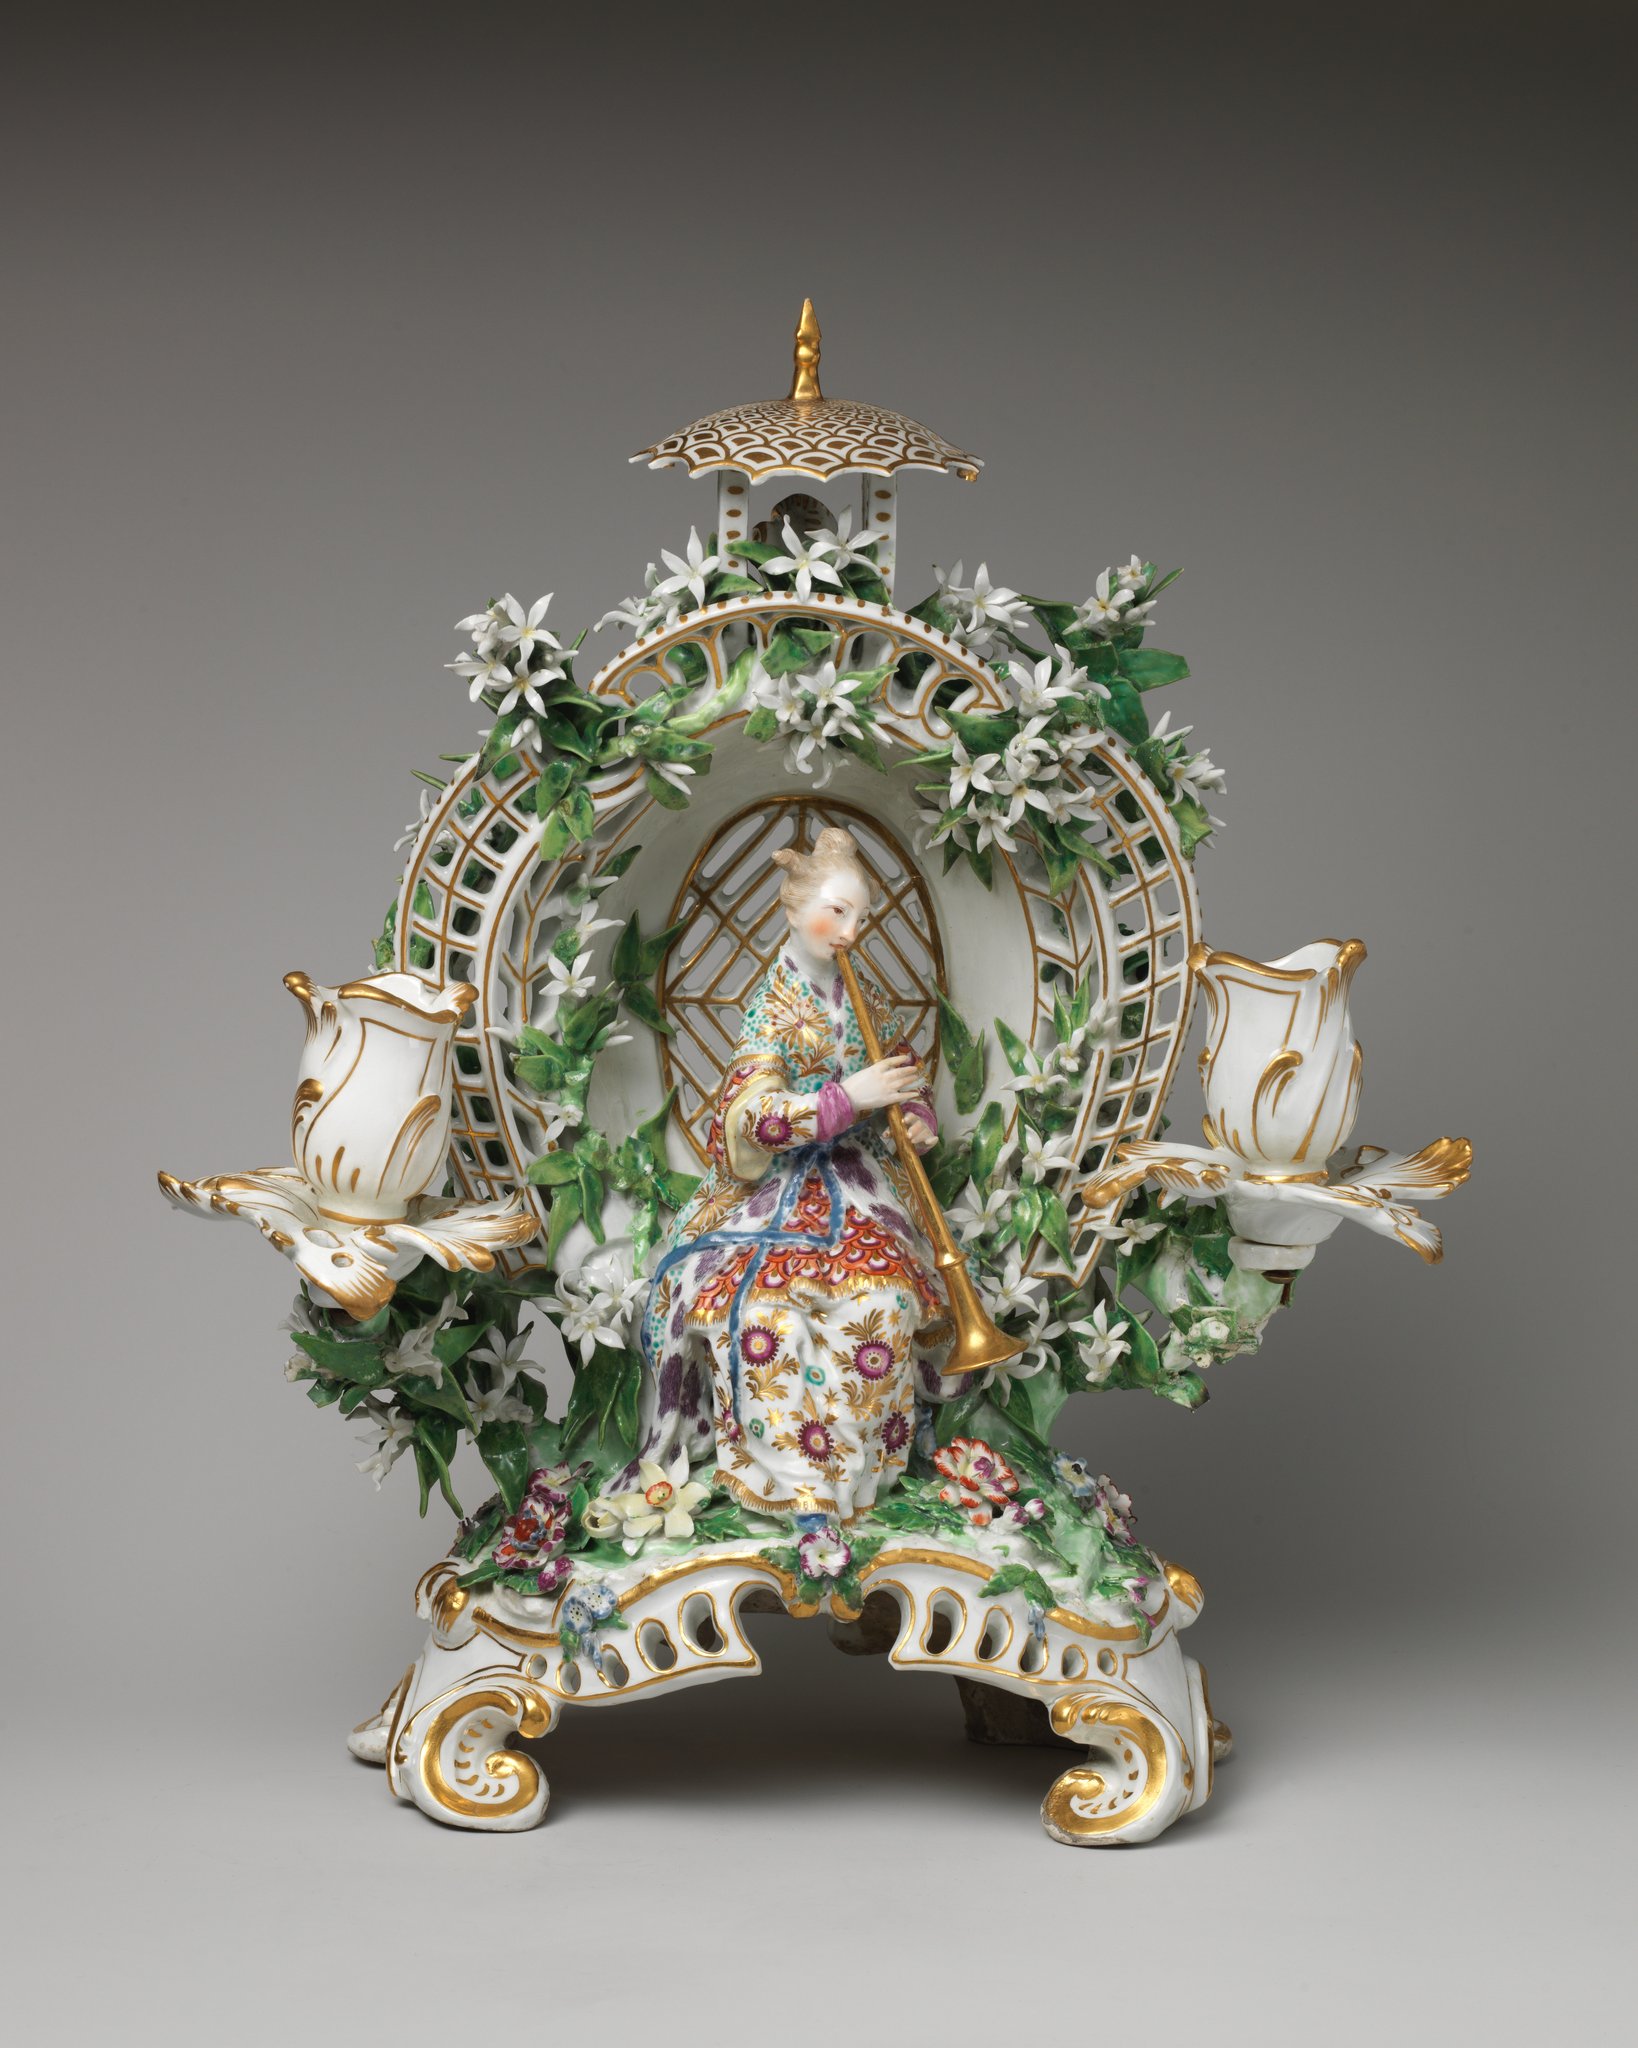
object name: candelabrum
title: Candelabrum (one of a pair)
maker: chelsea porcelain manufactory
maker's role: factory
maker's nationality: british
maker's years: 1744-1784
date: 1765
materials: soft paste porcelain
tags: musical instruments,chinoiserie,women,flowers,musicians